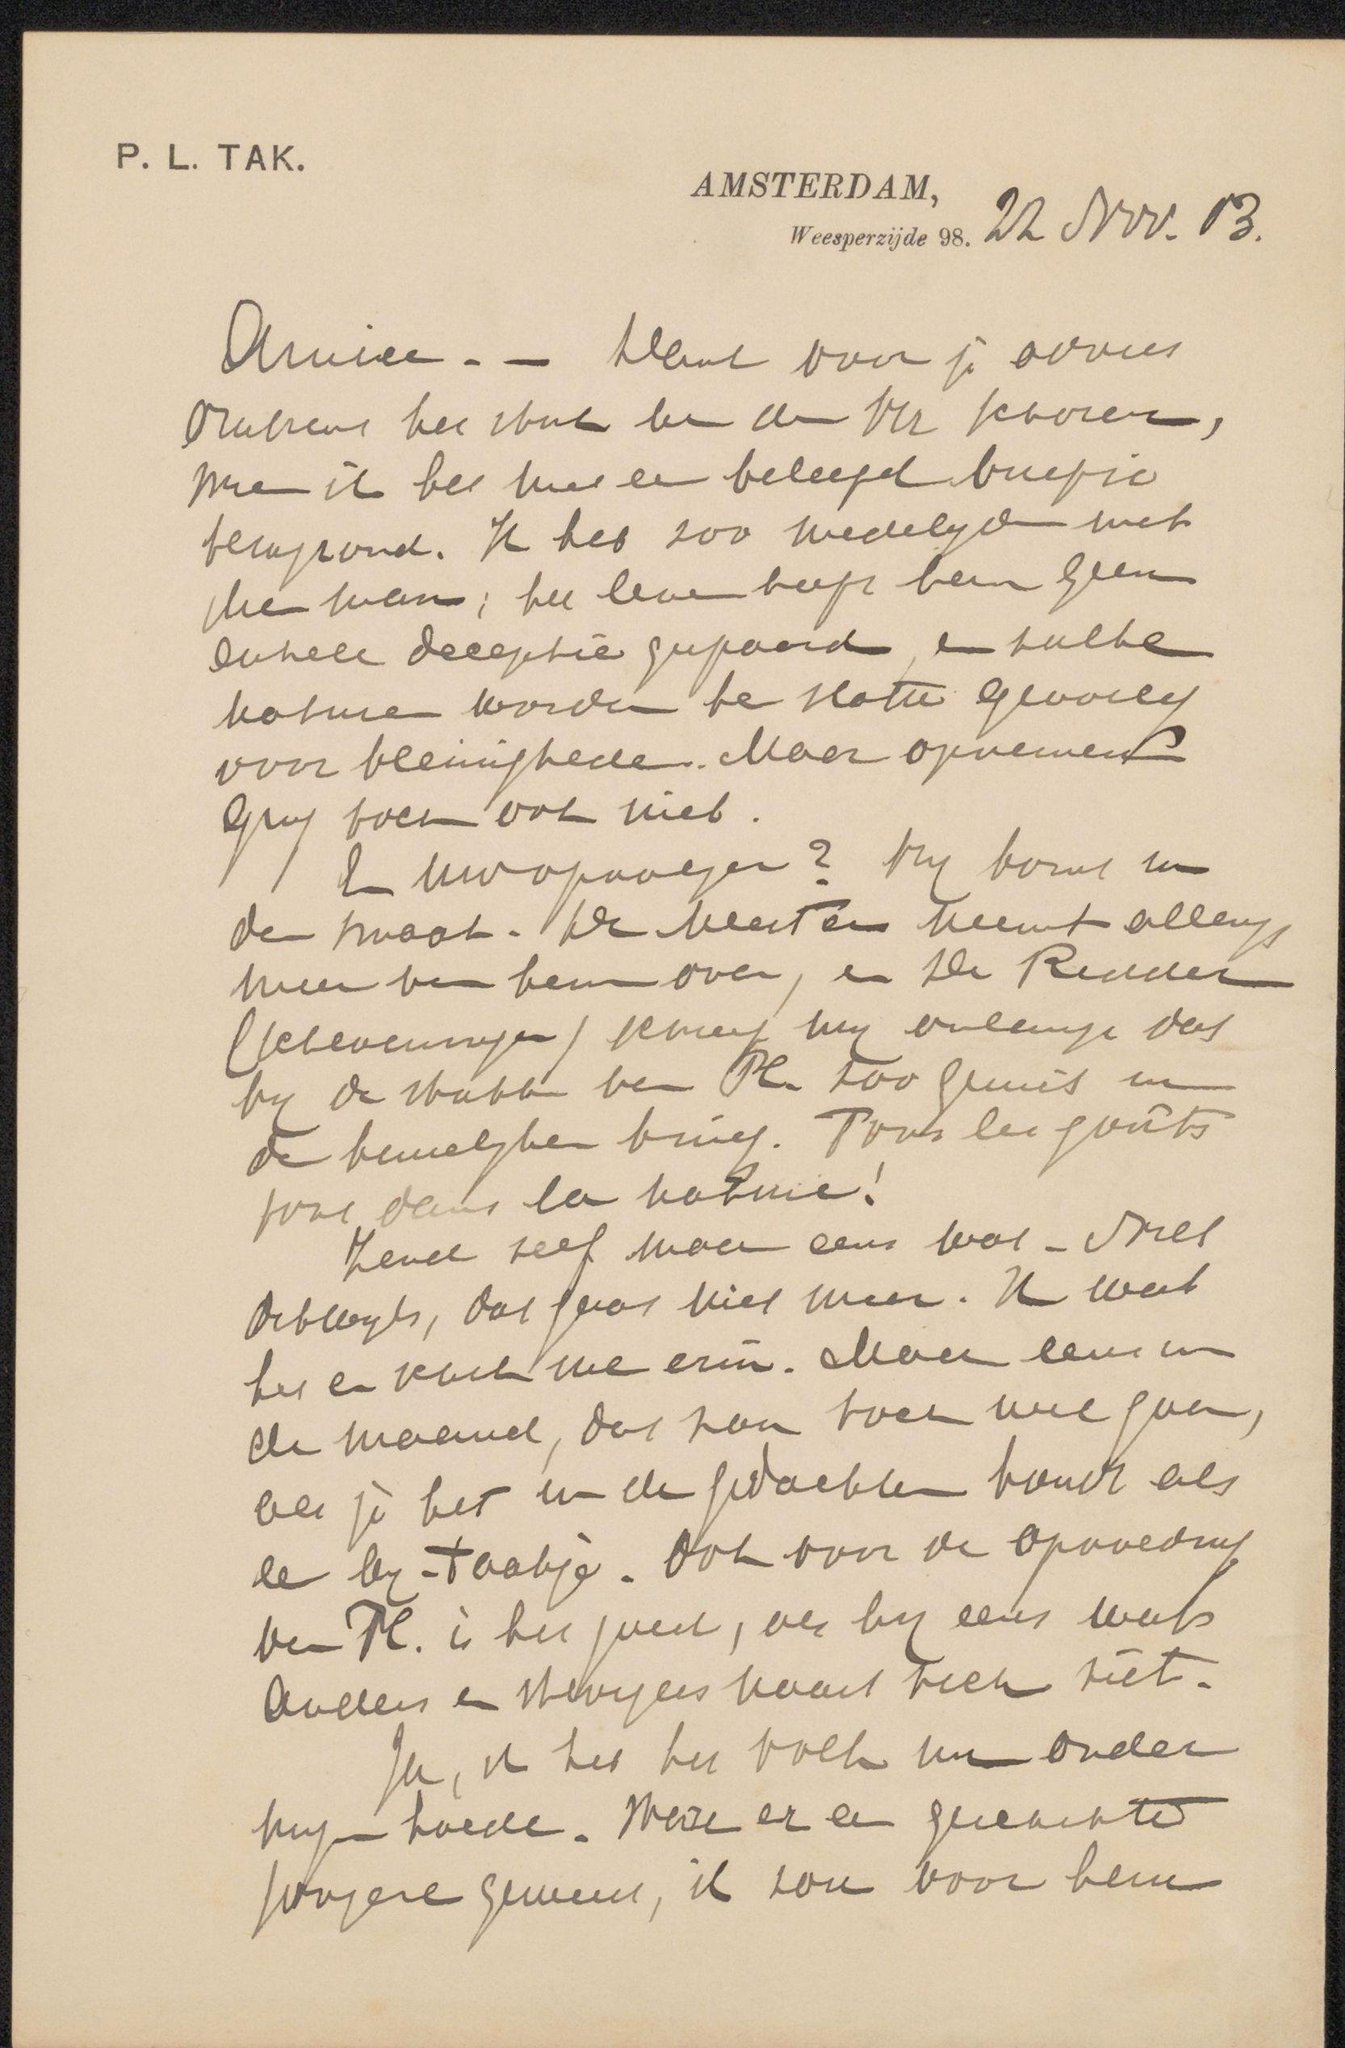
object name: letter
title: Brief aan Jan Veth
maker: pieter lodewijk tak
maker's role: politician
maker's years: 1848-1907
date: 1903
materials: ink, paper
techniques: pen, printing, writing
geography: amsterdam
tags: dordrecht, painter, draughtsman, designer, jan veth, publisher, j.h. schorer, leiden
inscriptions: collector's mark: ‘RPK’, watermark